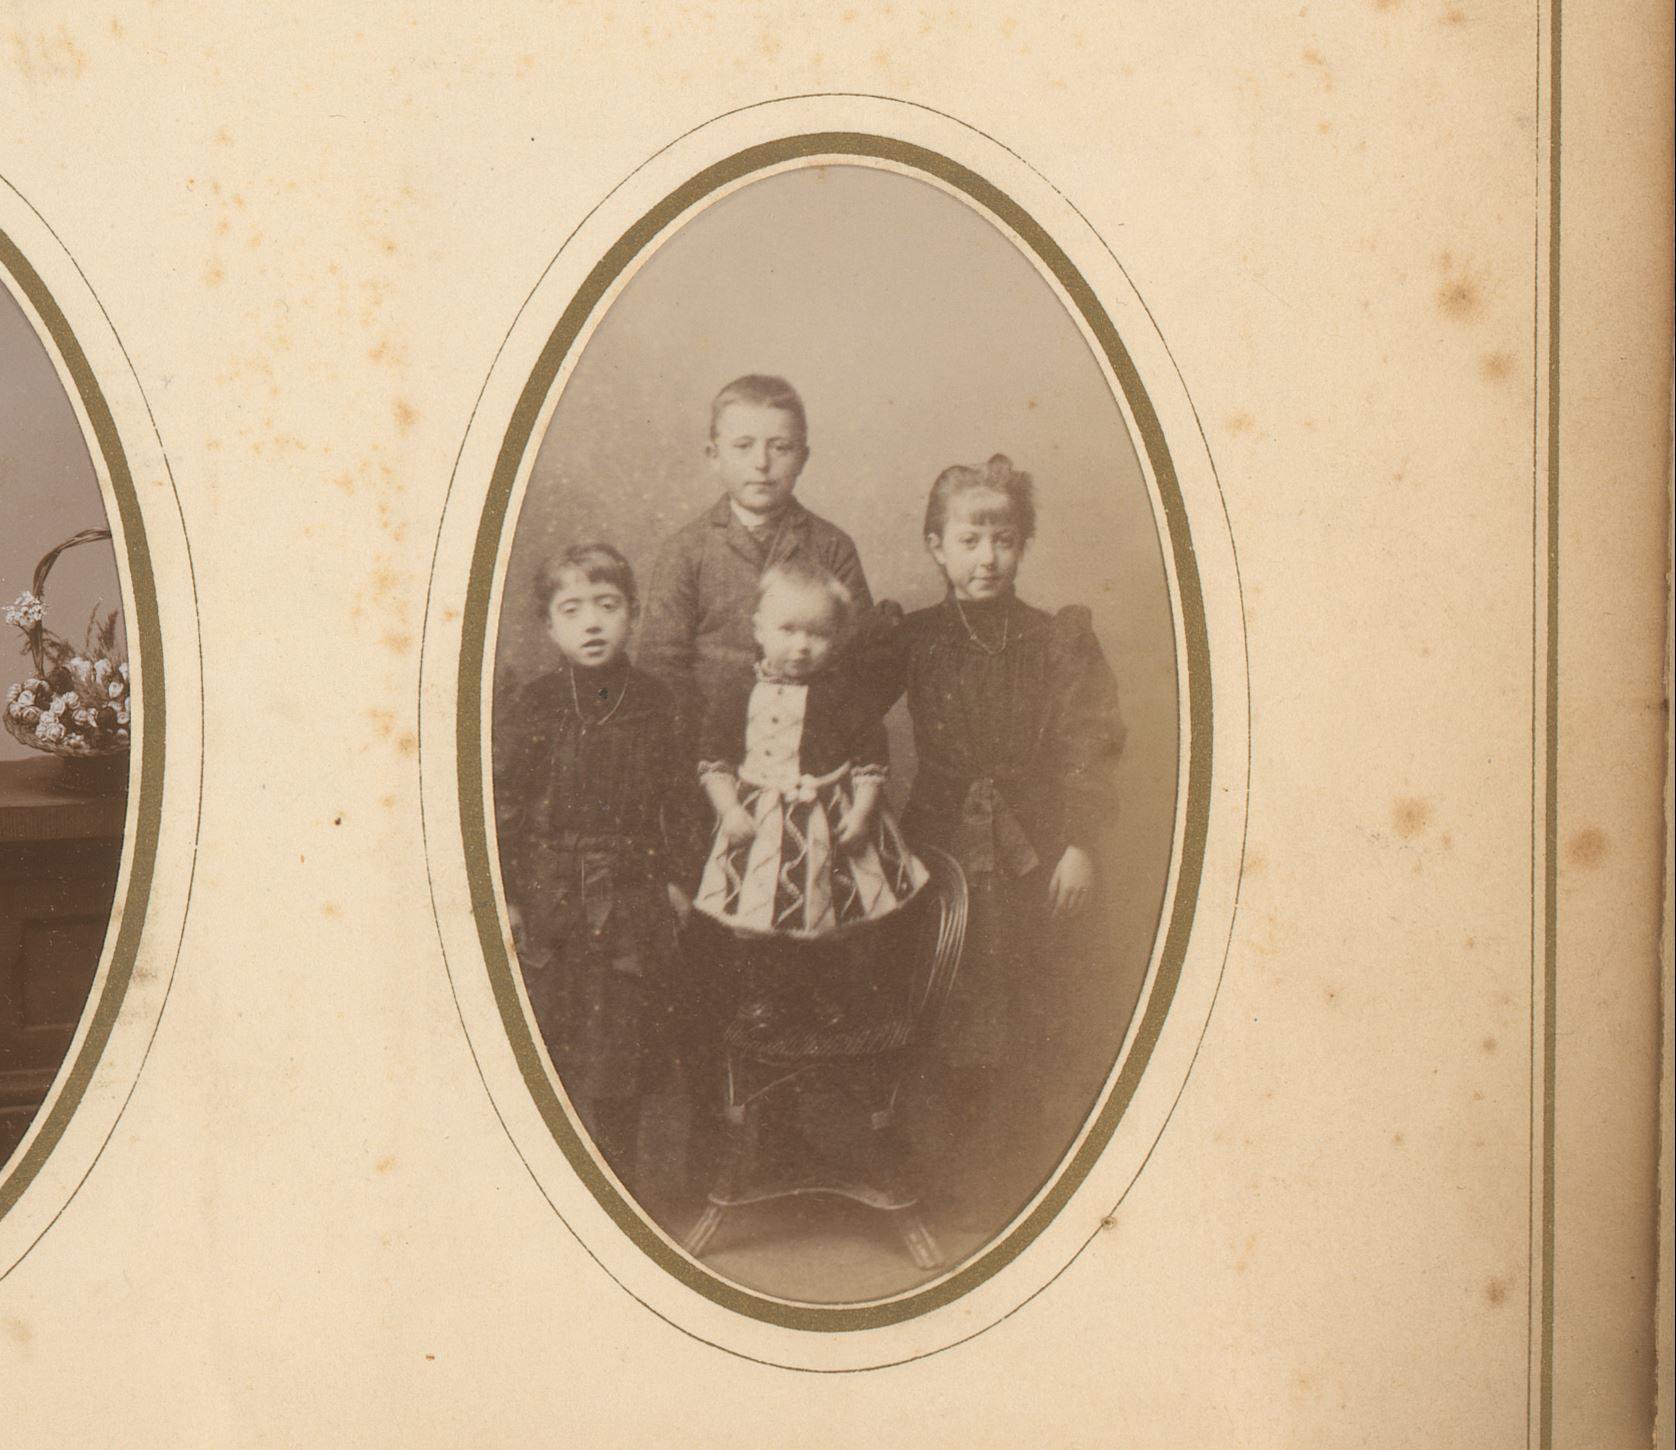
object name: album leaf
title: Groepsportret van vier kinderen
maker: johan gerard lubbers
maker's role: fotograaf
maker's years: 1849-1923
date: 1891-1907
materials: cardboard, photographic support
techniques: albumen print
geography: rotterdam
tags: boy (child between toddler and youth), toddler (female), girl (child between toddler and youth) (+ two persons), anonymous historical persons portrayed in a group, in a group-portrait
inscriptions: inscription: ‘J.G. Lubbers/ Photographe/ van der Takstraat 8/ Rotterdam./ De plaat blijft voor nabestelling bewaard./ Vergrootingen in ieder afmeting tot levensgroot.’